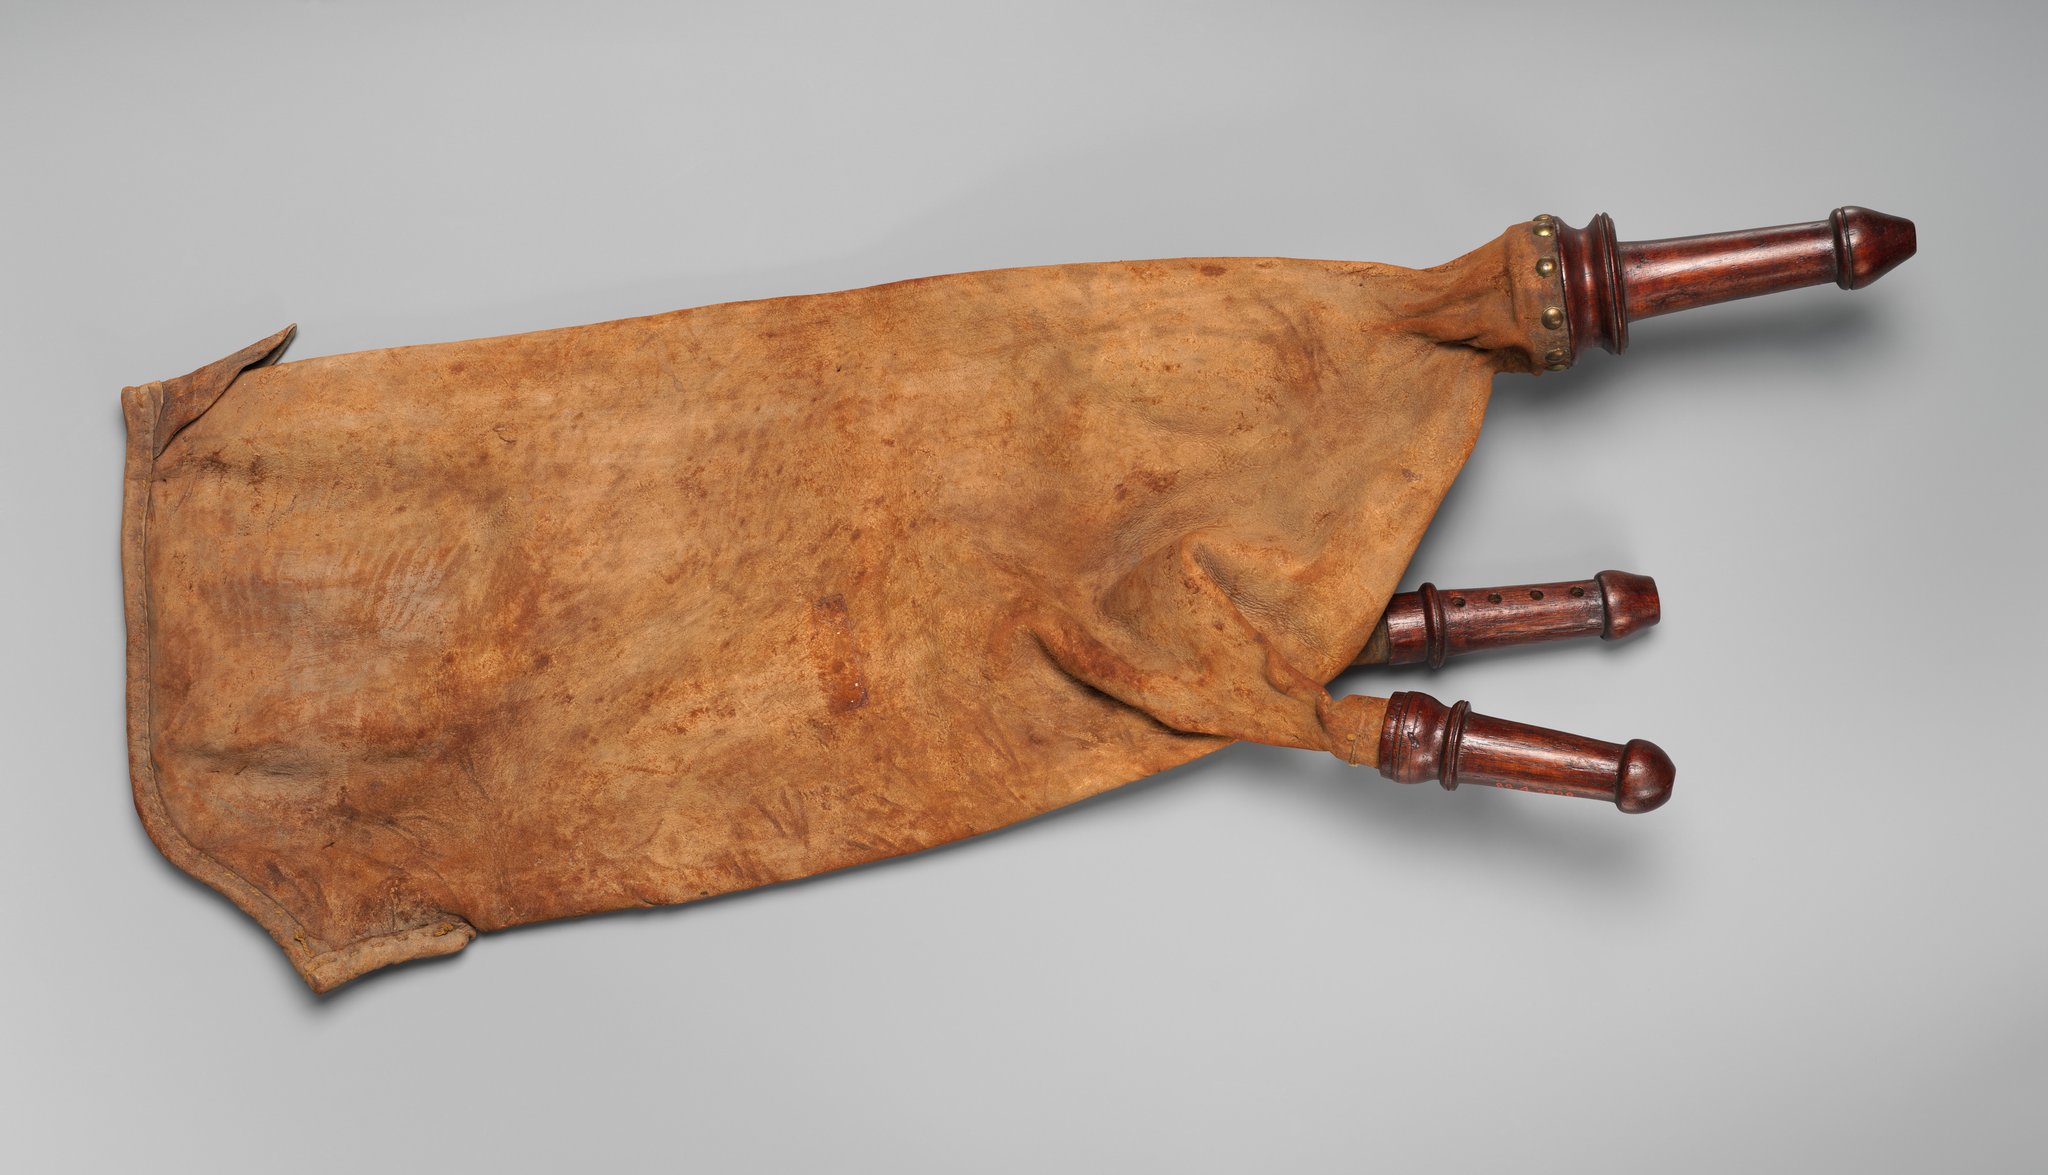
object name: sruti upanga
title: Zitty (Bagpipe)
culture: indian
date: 1801-1900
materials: leather, skin, wood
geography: india